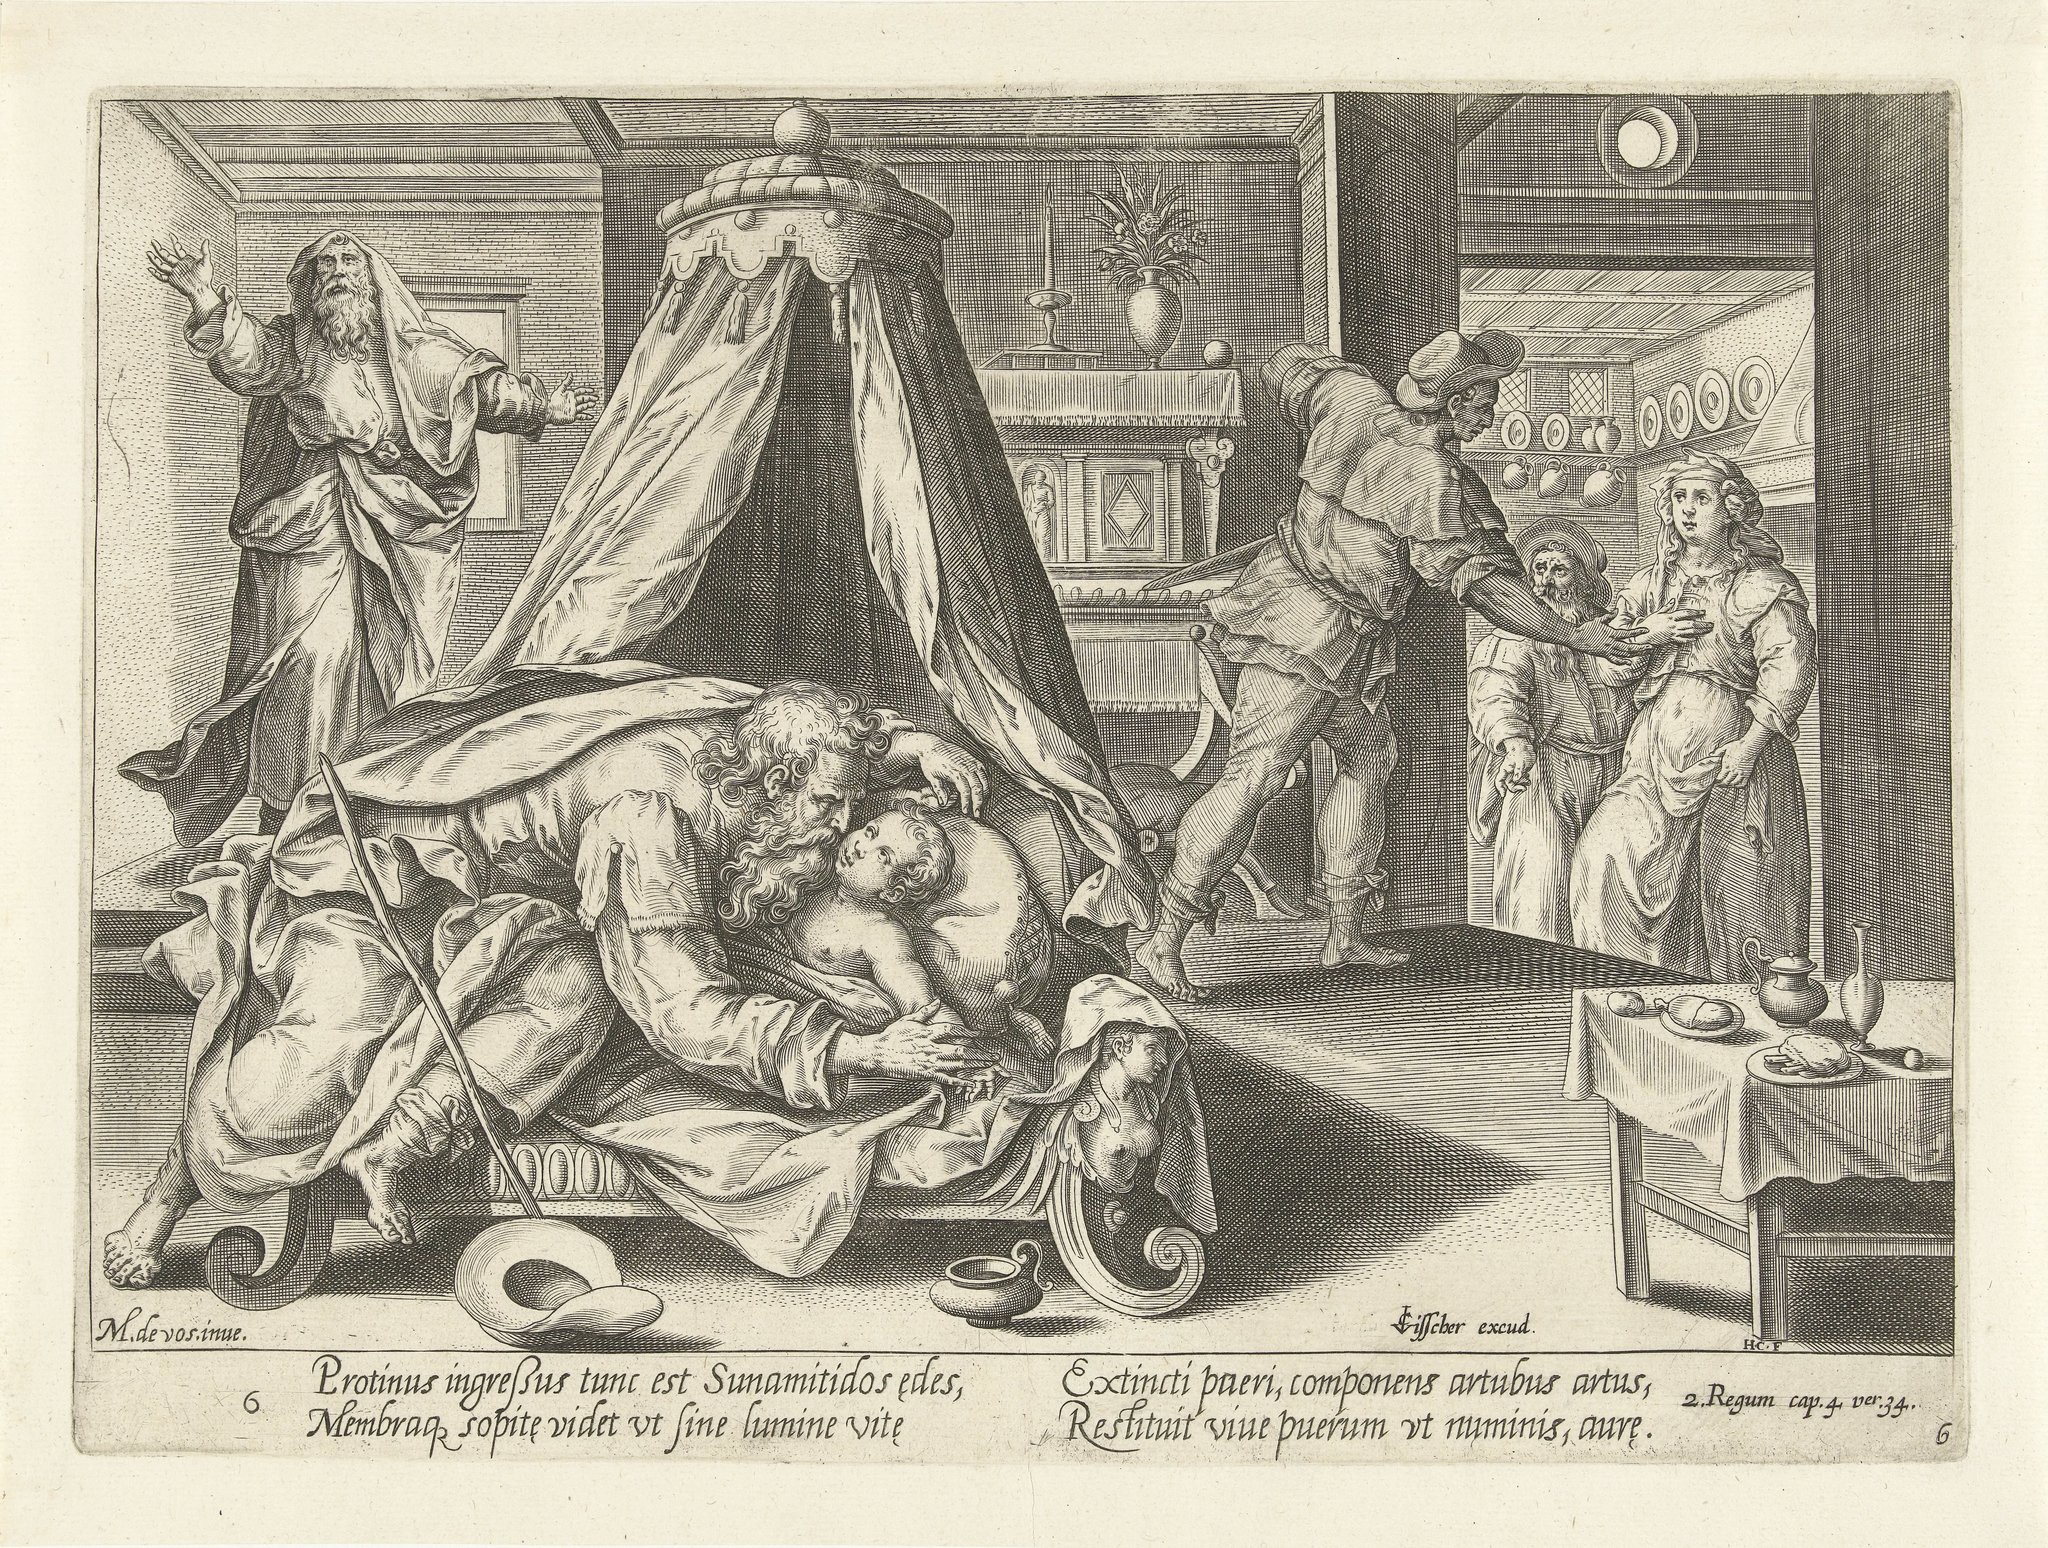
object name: print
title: Elisa wekt de zoon van de Sunnemitische vrouw terug tot leven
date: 1643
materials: paper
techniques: engraving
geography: antwerp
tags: elisha stretches himself out upon the child of the shunammite woman, gehazi fetches the shunammite woman; when she sees her child alive she falls at elisha's feet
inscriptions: collector's mark: Lugt 2228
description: Elisa gaat liggen op het bed van de zoon van de Sunnemitische vrouw. Hij kust de jongen en brengt hem terug tot leven. Op de achtergrond meldt men het goede nieuws aan de moeder. De prent heeft een Latijns onderschrift en maakt deel uit van een serie over Elisa en de Sunnemitische vrouw.